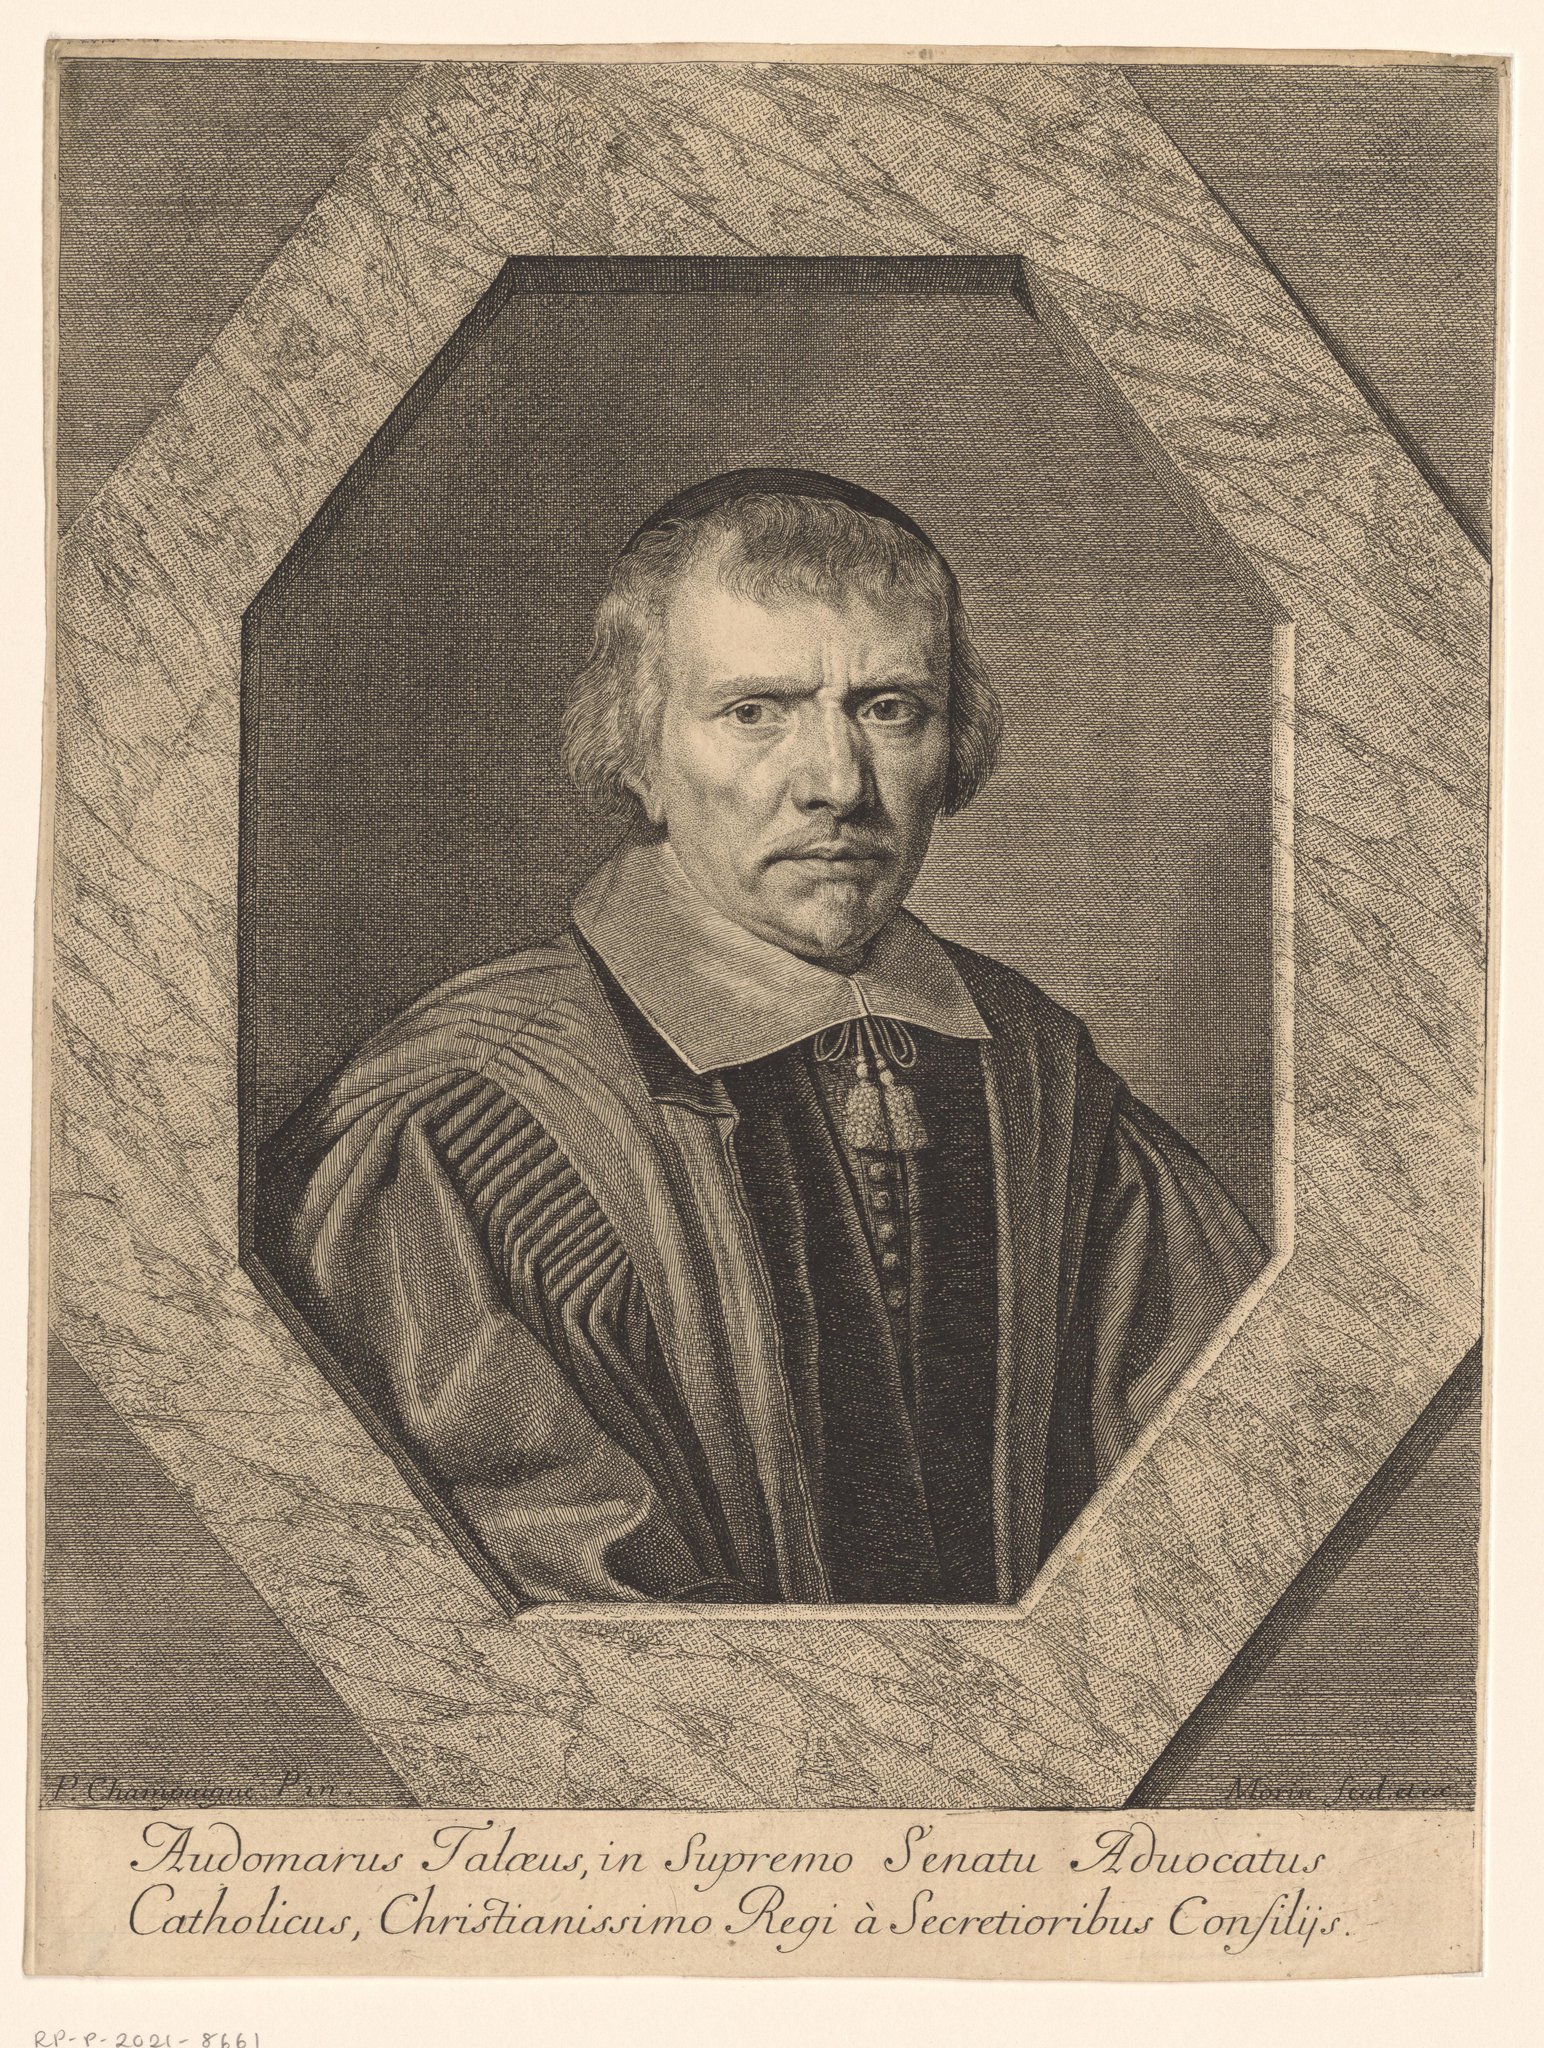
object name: print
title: Portret van Omer Talon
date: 1625-1650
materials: paper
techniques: engraving, etching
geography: paris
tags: historical persons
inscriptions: inscription: ‘Claude Auguste Mariette 1693’